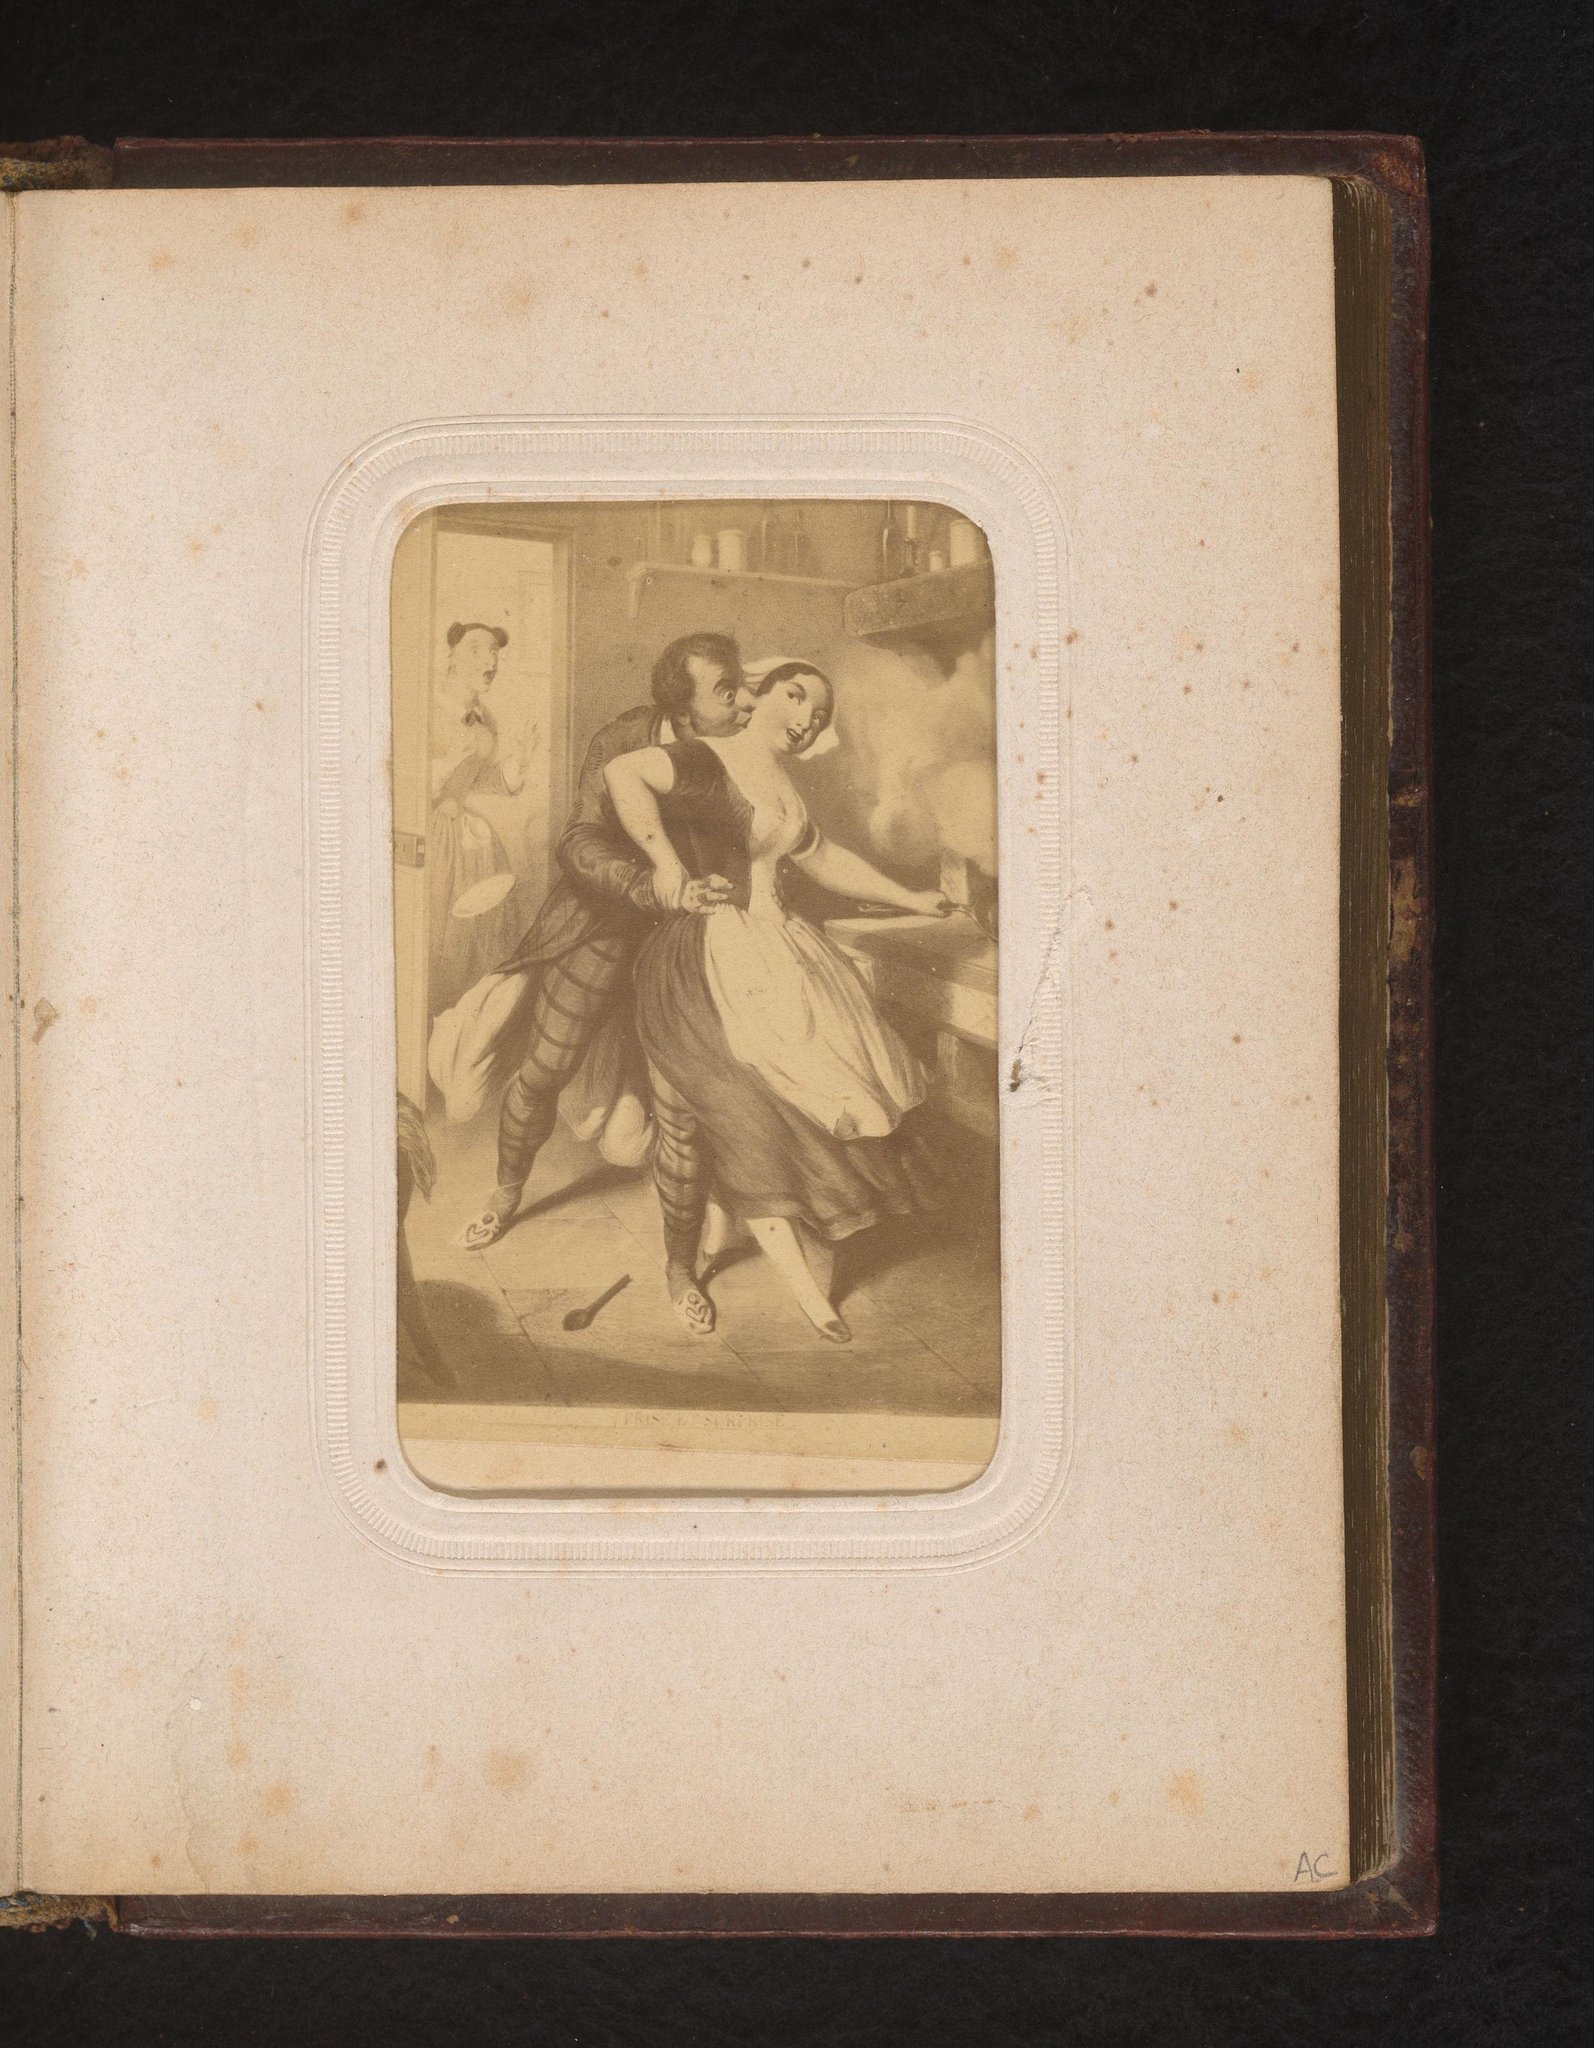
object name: carte de visite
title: Fotoreproductie van een tekening van een man die een vrouw in de keuken verrast en haar nek kust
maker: Anonymous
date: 1860-1900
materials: cardboard, photographic support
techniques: albumen print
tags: kitchen, (lovers) kissing each other